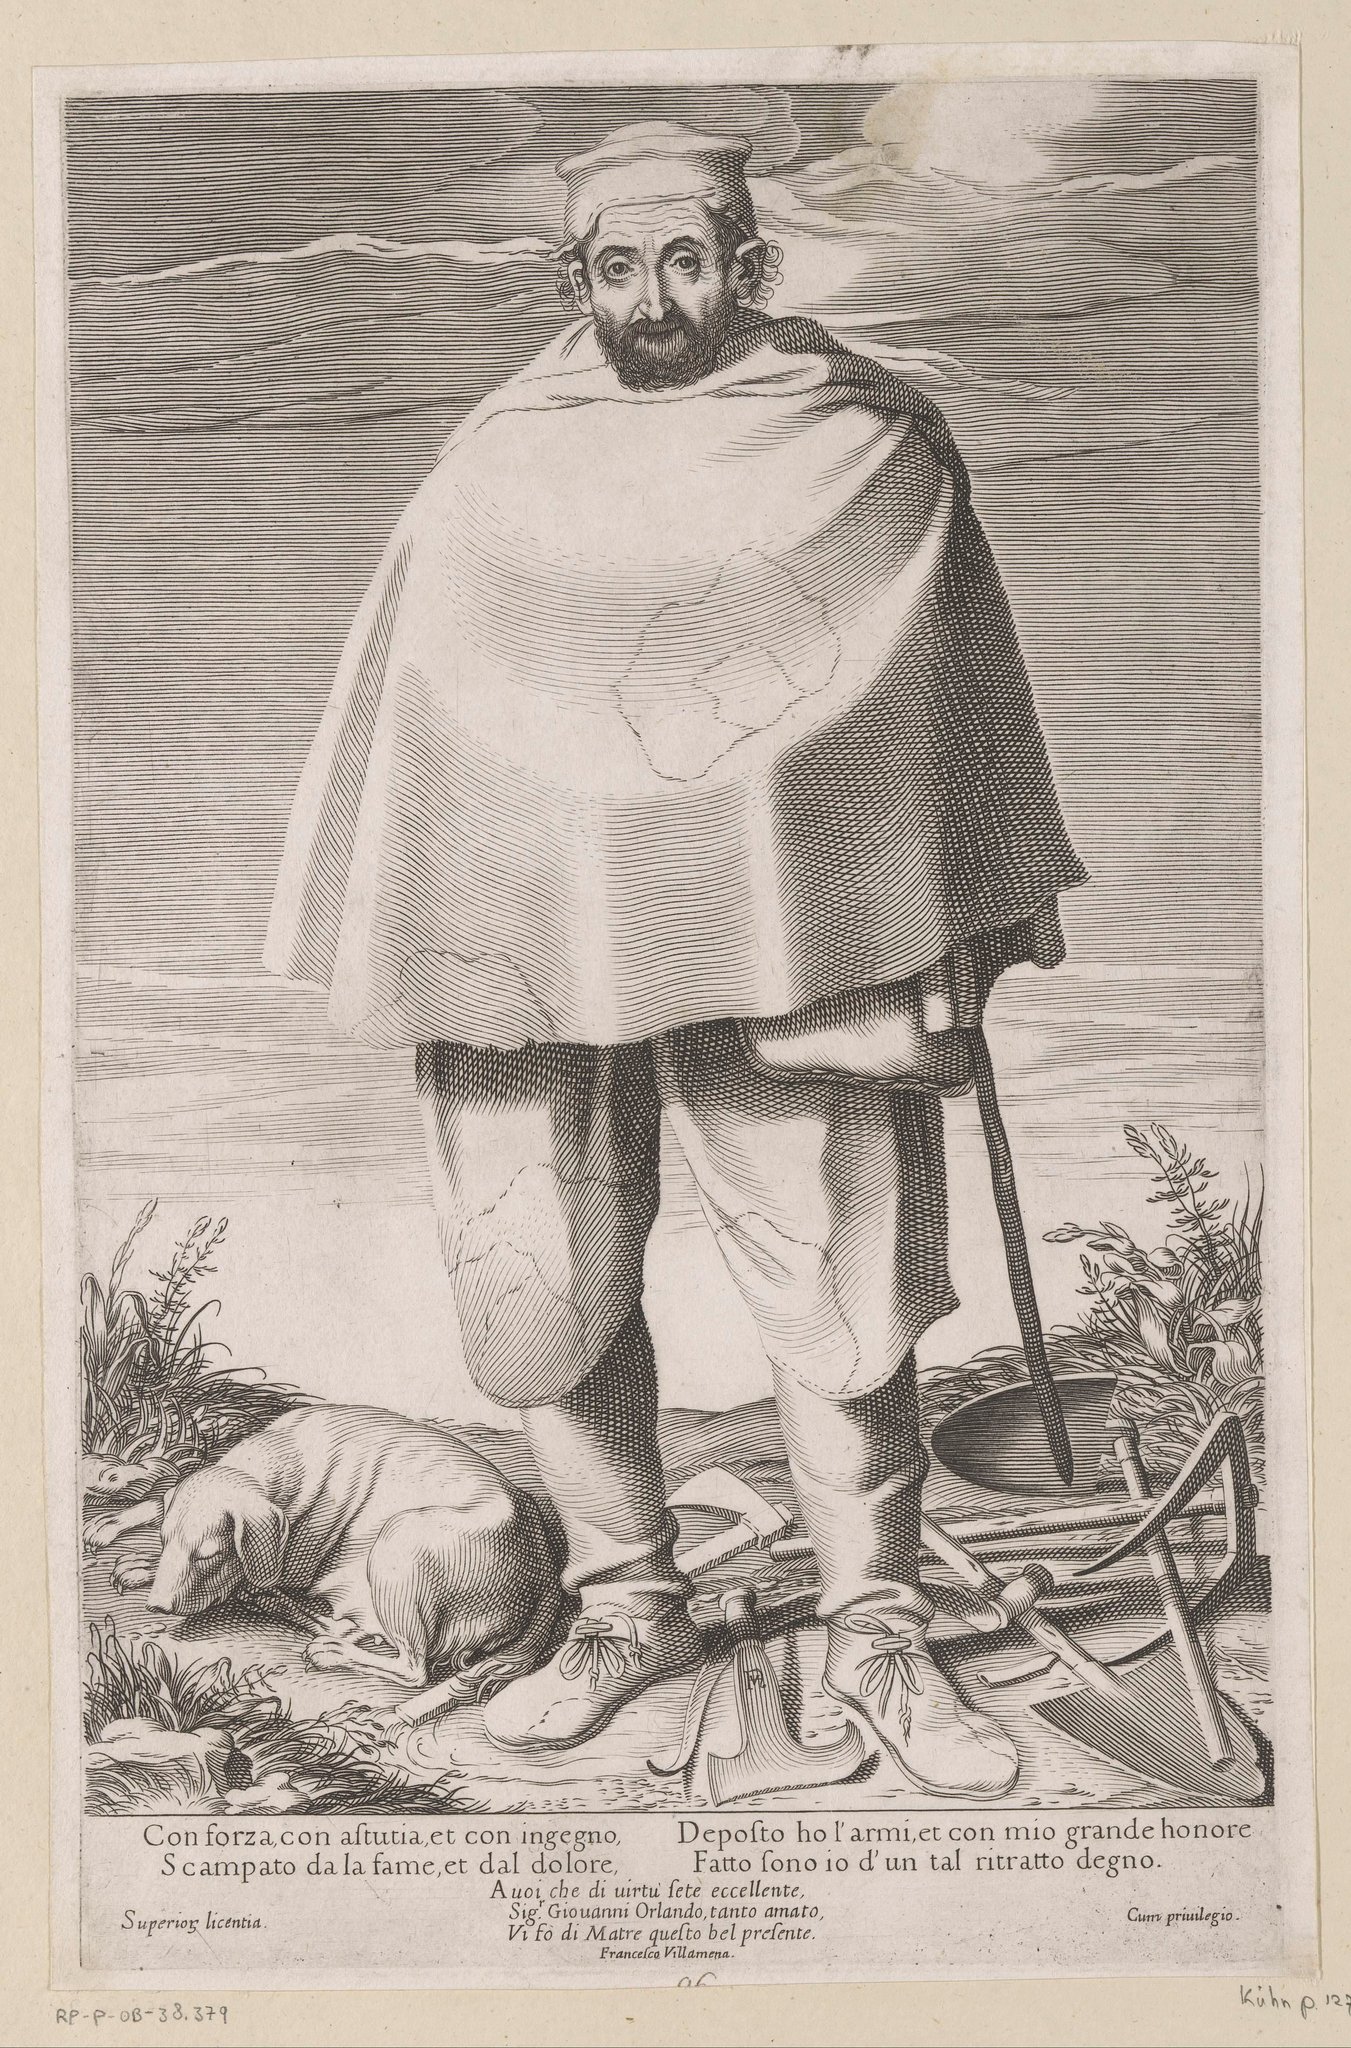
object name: print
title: Tuinman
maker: francesco villamena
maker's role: draughtsman, painter, print maker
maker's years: 1566-1624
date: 1576-1624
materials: paper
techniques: engraving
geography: vatican city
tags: gardening-tools, 'cris de paris', cries of london, etc.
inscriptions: number: ‘06’, collector's mark: Lugt 240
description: Een staande man met aan zijn voeten een hond en tuingereedschap. Latijnse versregels in ondermarge.